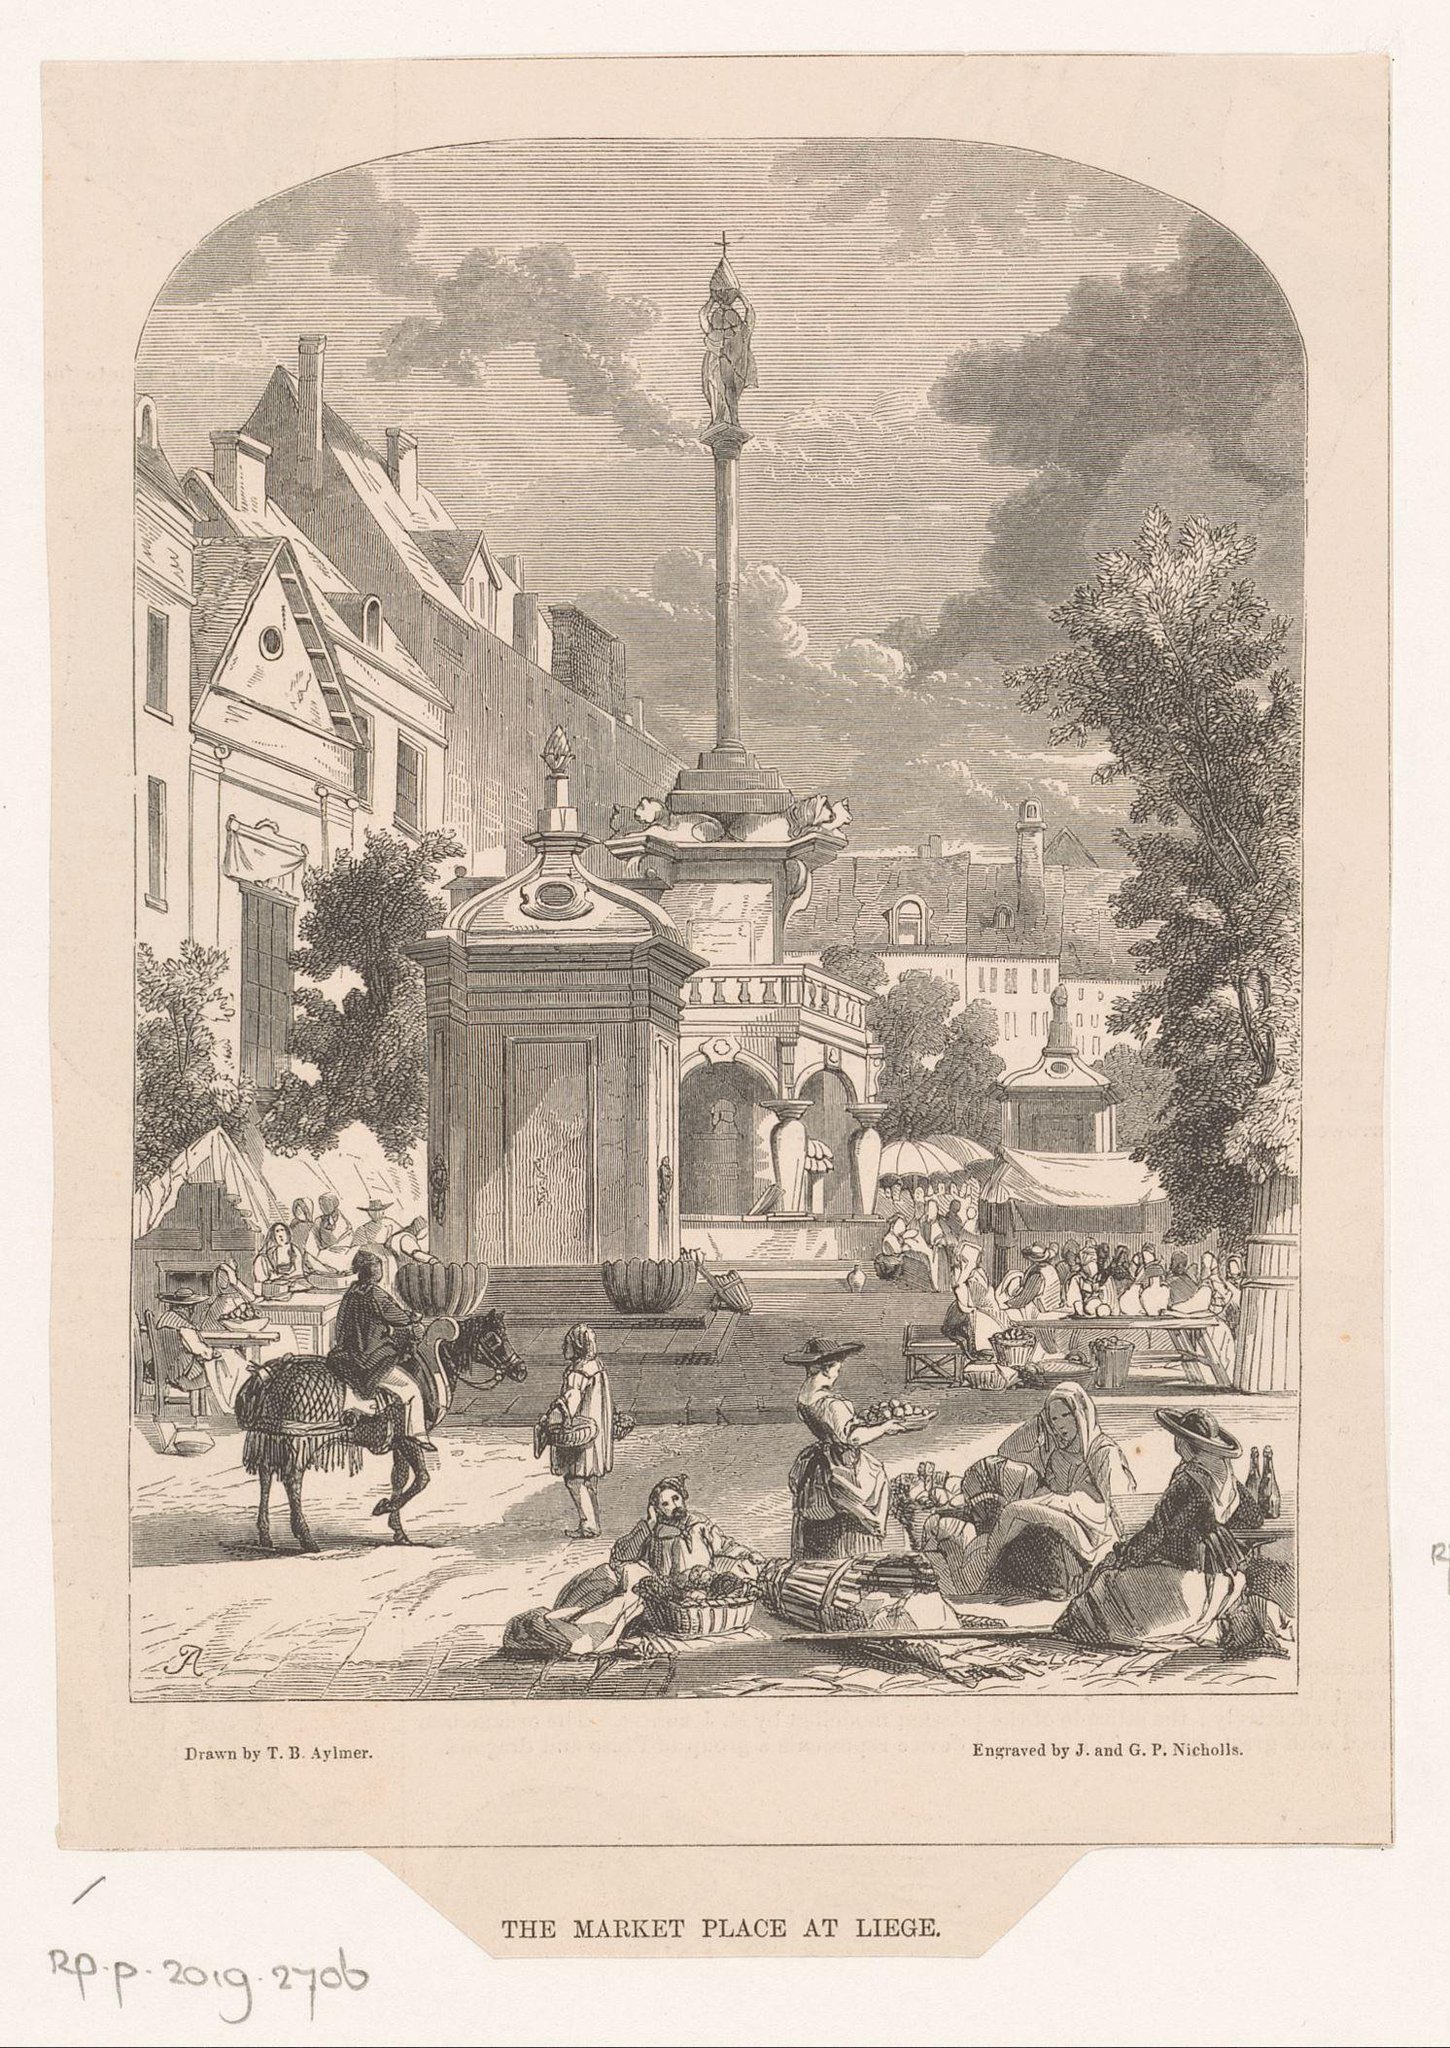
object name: print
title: The market place at Liege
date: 1838-1855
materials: paper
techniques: letterpress printing, engraving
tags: square, place, circus, etc., ornamental fountain, liège